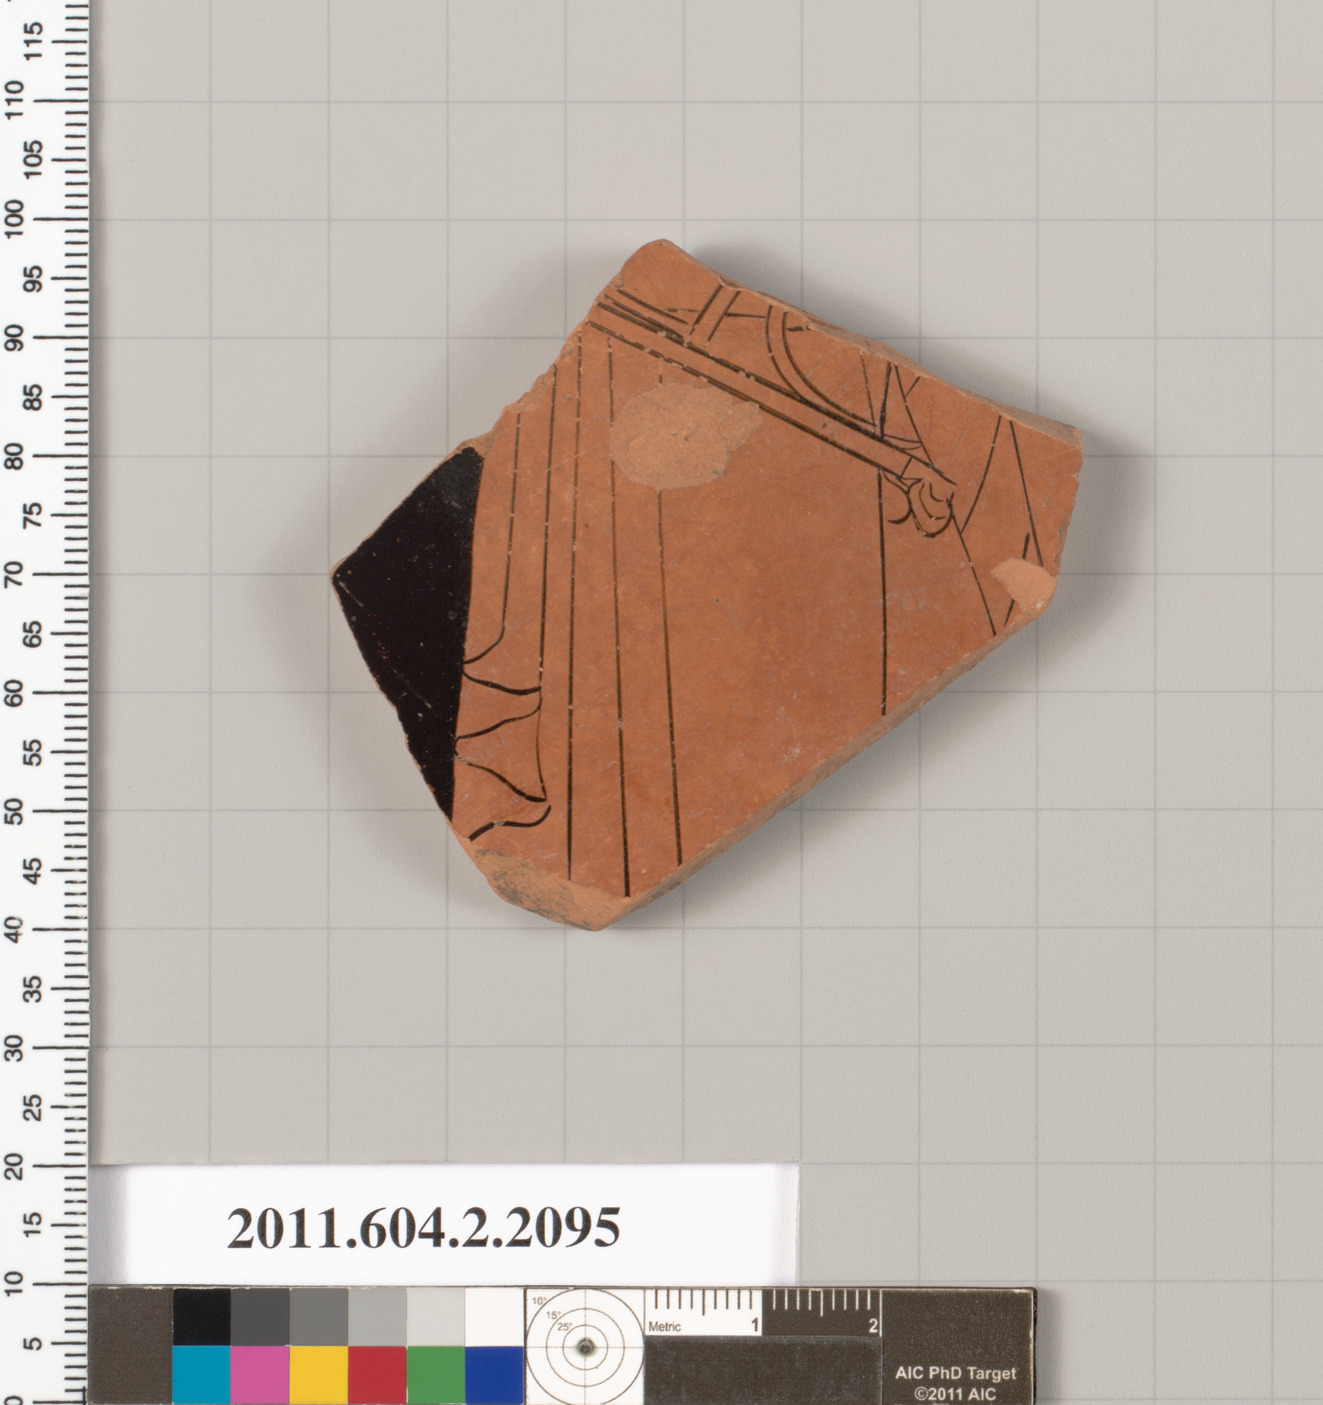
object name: krater fragment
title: Terracotta fragment of a krater (bowl for mixing wine and water)?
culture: greek, attic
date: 490-470 BCE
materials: terracotta